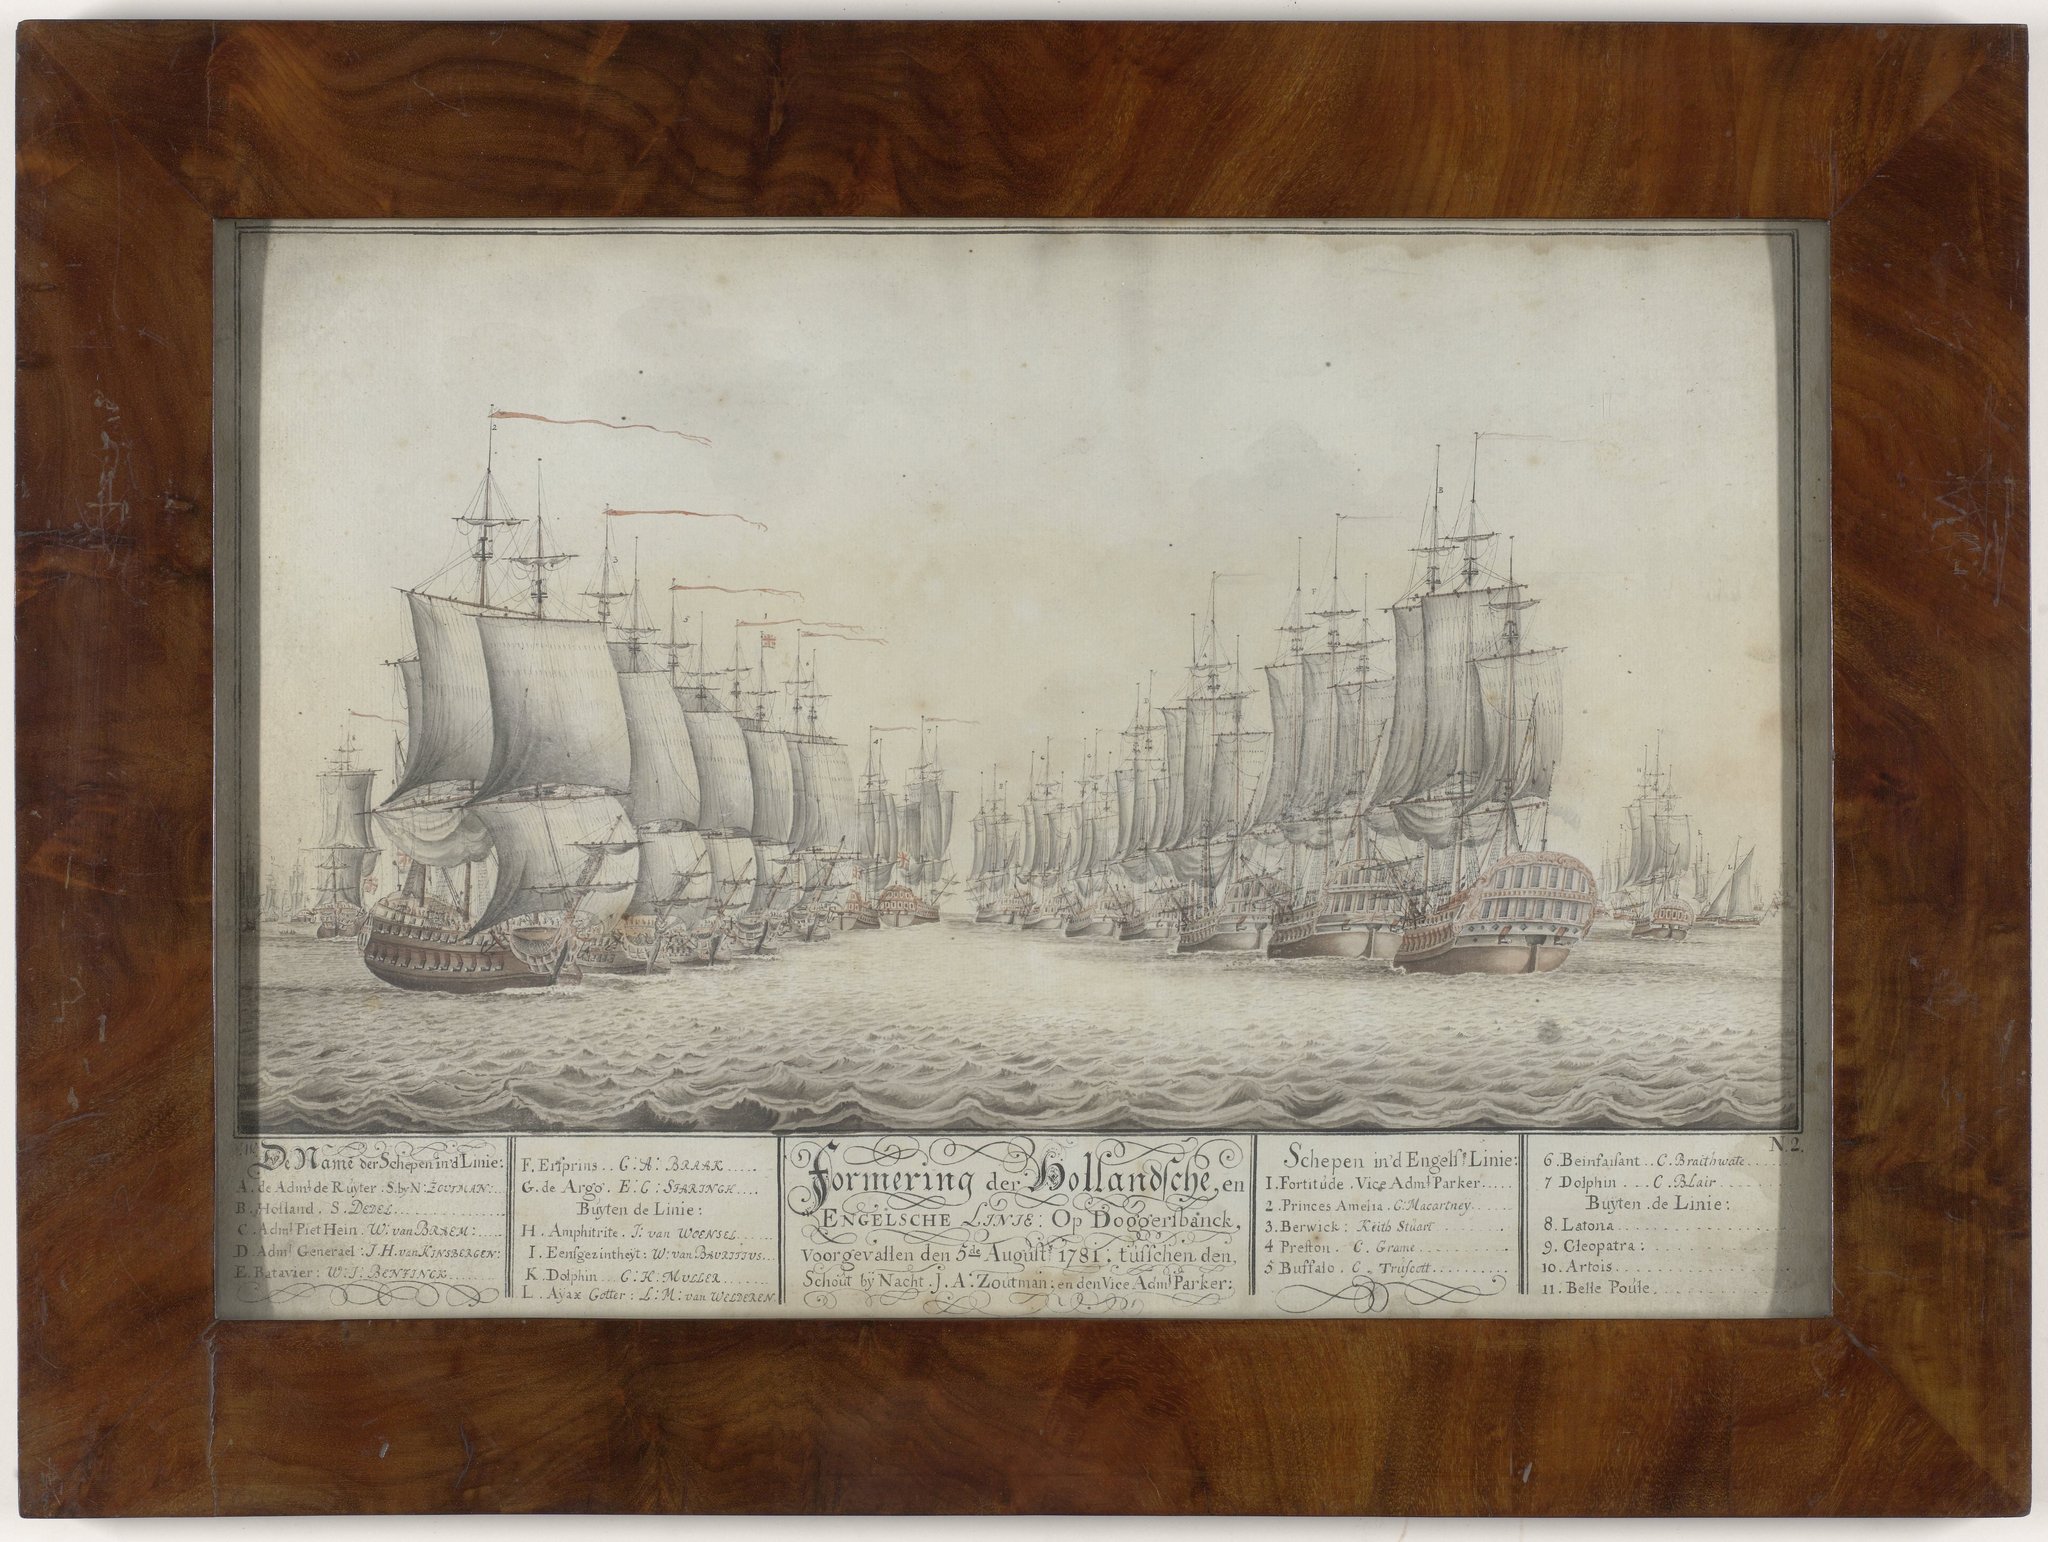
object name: drawing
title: The Action off Dogger Bank (5 August 1781)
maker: j. weuyster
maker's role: draughtsman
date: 1783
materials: glass, ink, wood, paper, watercolor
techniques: brush, pen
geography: netherlands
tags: the hague, johan arnold zoutman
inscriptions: inscription, bottom left and right: identification of the Dutch and British ships, inscription, right: ‘N. 2.’, signature, left: ‘J.W.’, caption, bottom centre: ‘Formering der Hollandsche en / Engelsche Linie Op Doggersbanck / voorgevallen den 5de Augusts 1781 tusschen den / Schout bij Nacht J.A. Zoutman en den Vice Adml. Parker’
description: Tekening met gecalligrafeerde titel. Twee rijen schepen (driemasters), wigvormig in linie liggend t.o. elkaar op voorgrond ver uit elkaar. schepen in l. rij zijn met boegsprieten schuin naar voren gericht. Schepen in r. rij liggend met bakboordzijde naar l. rij gericht. Bij de masttoppen zijn bij de l. rij cijfers, en bij de r. rij letters aangebracht. Corresponderend met beschrijving onder tekening.